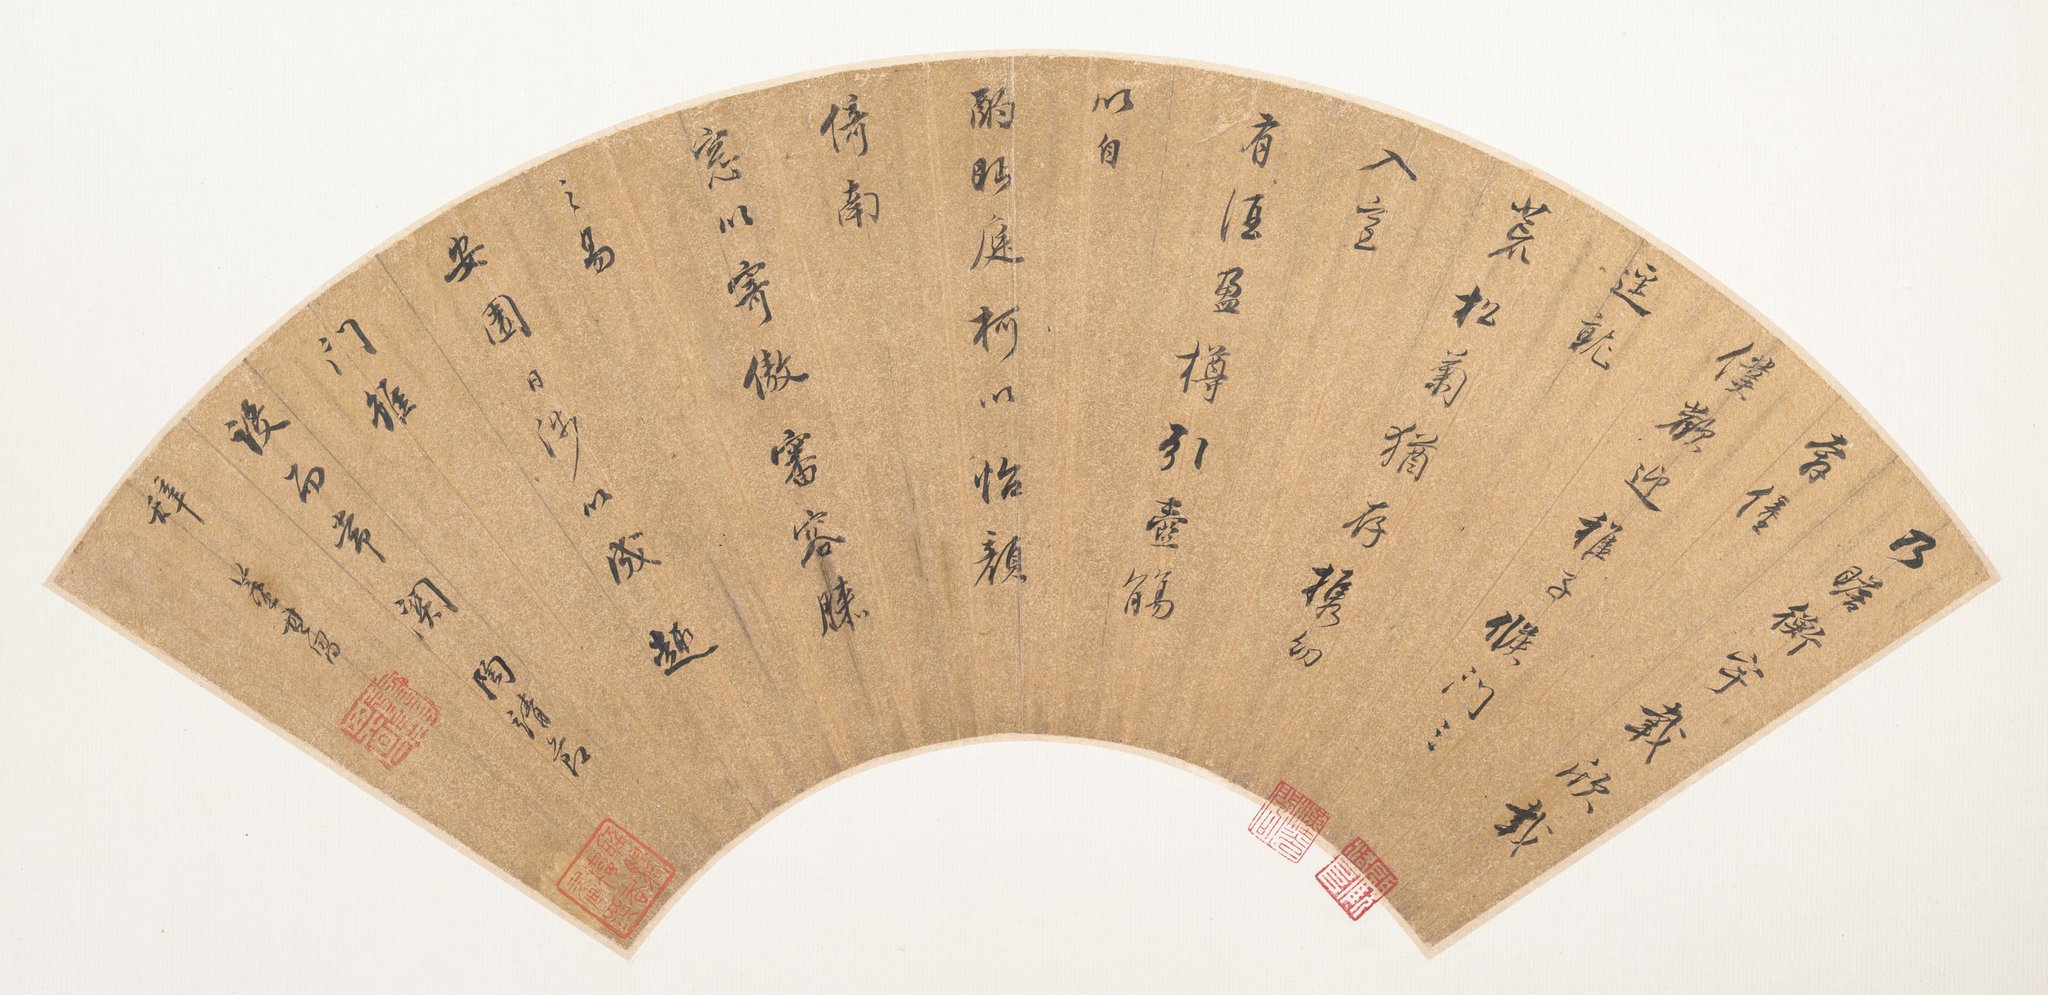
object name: folding fan mounted a an album leaf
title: Passage from Tao Qian's "Returning Home"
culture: chinese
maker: dong qichang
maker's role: artist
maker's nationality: chinese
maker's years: 1555-1636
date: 1555-1636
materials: gold, ink, paper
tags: poetry,calligraphy